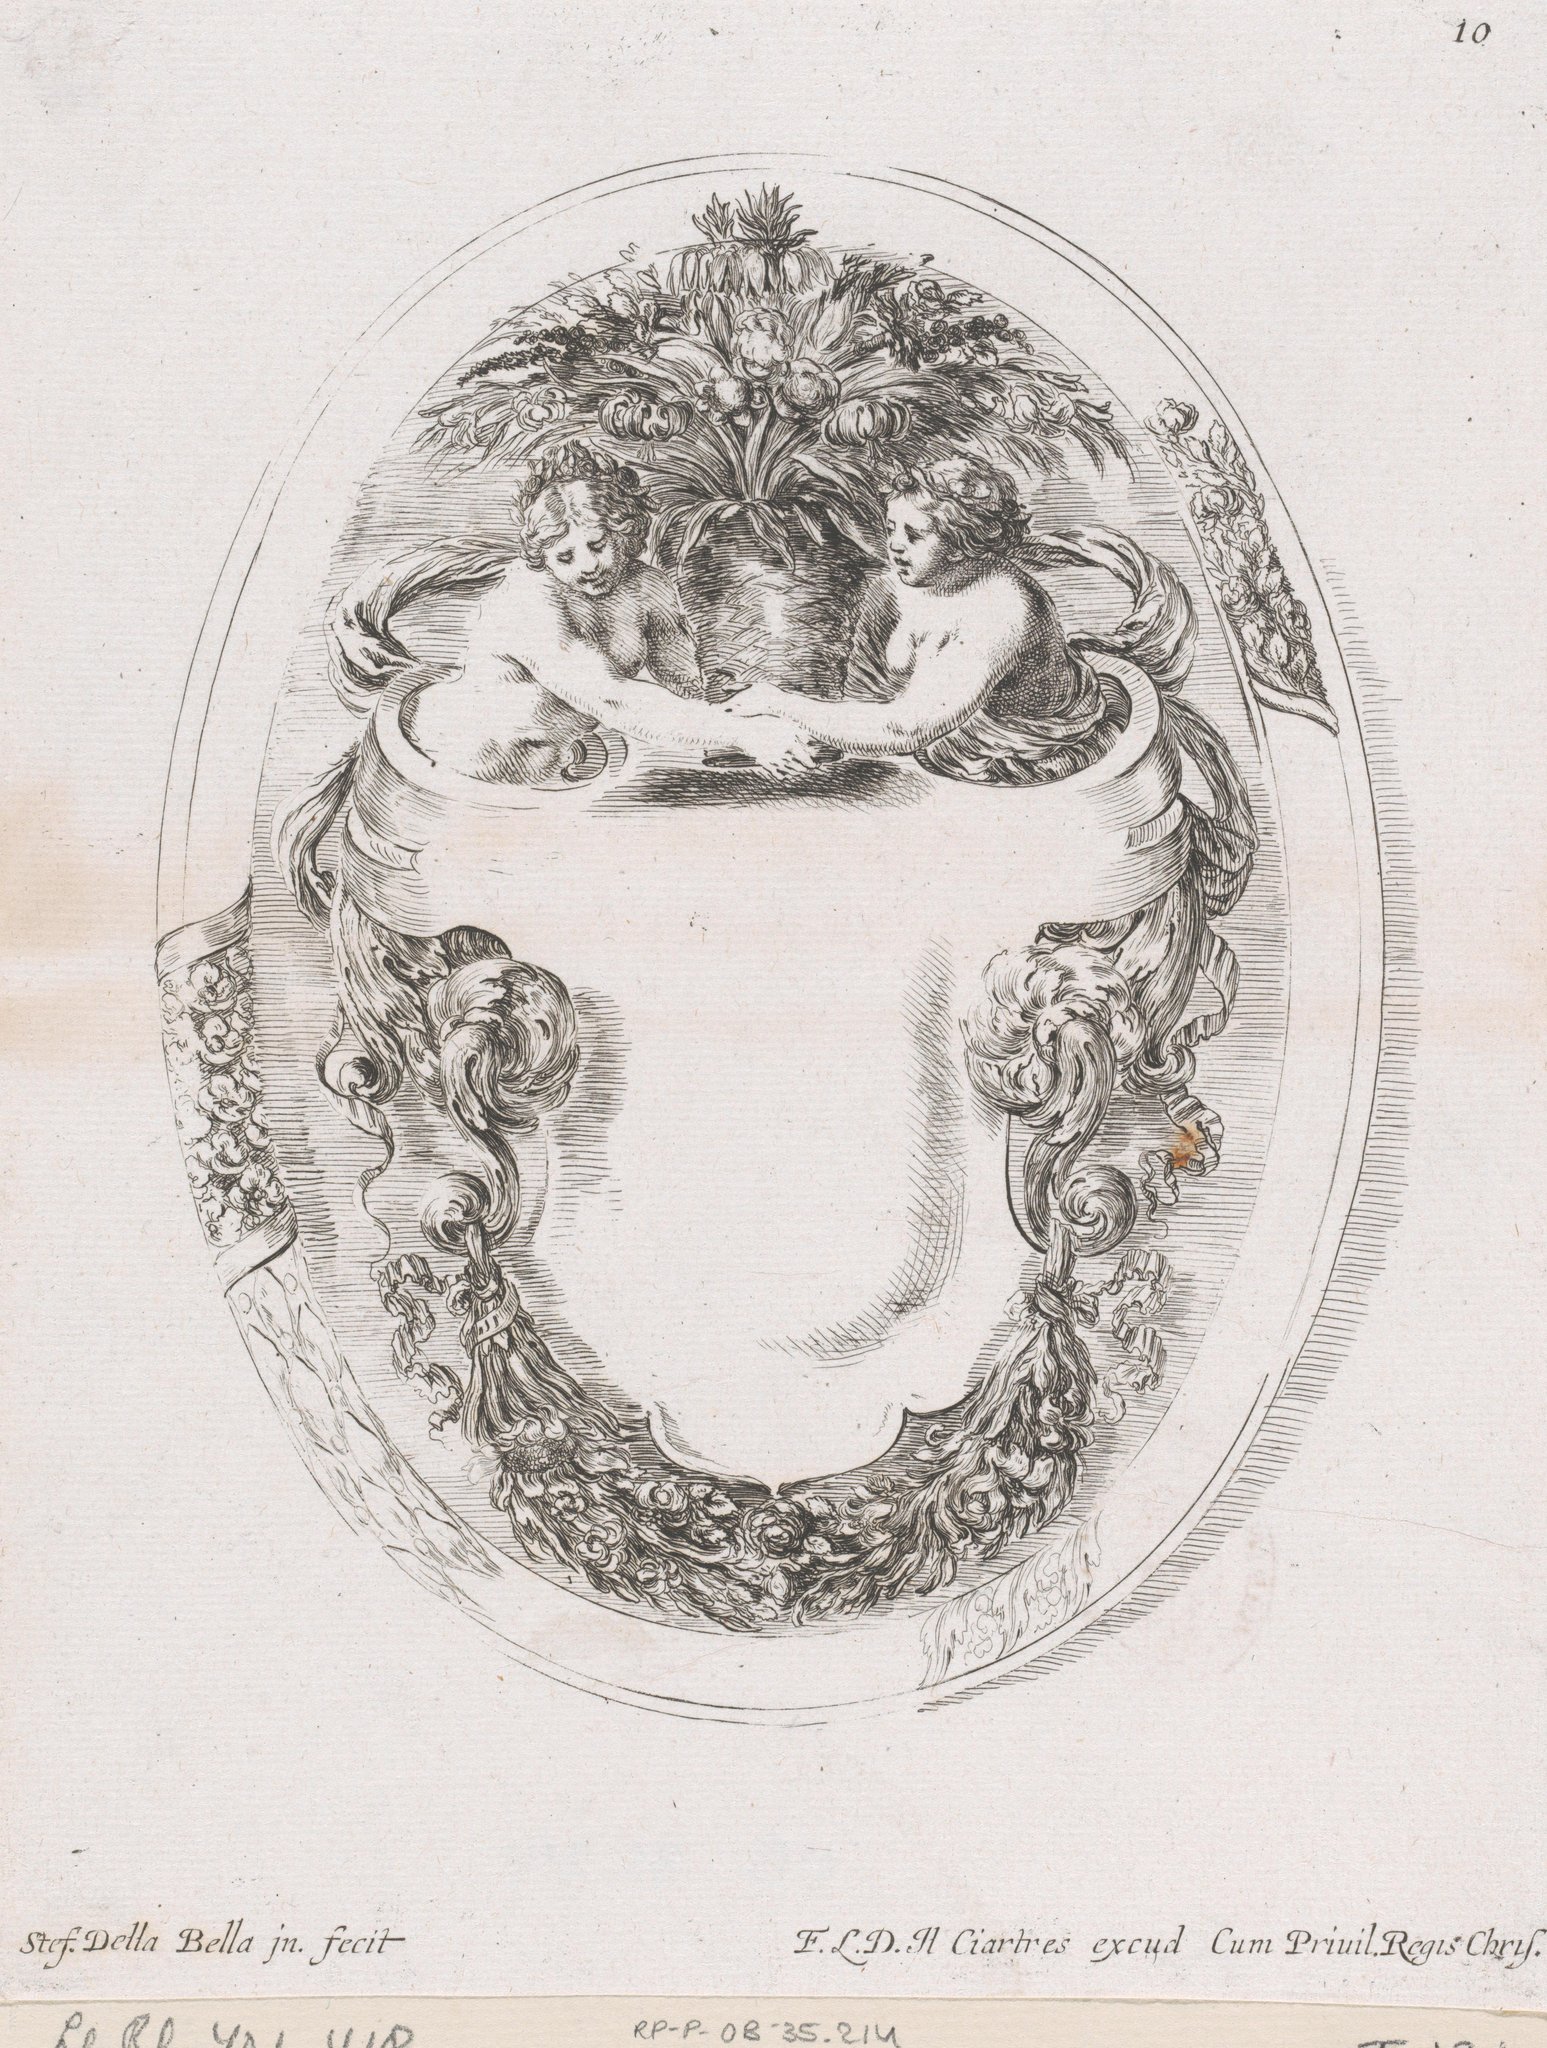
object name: ornament print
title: Cartouches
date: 1646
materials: paper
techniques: etching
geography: france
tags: foliage ~ ornament, ornament ~ cartouche, flowers in a vase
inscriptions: collector's mark: Lugt 240